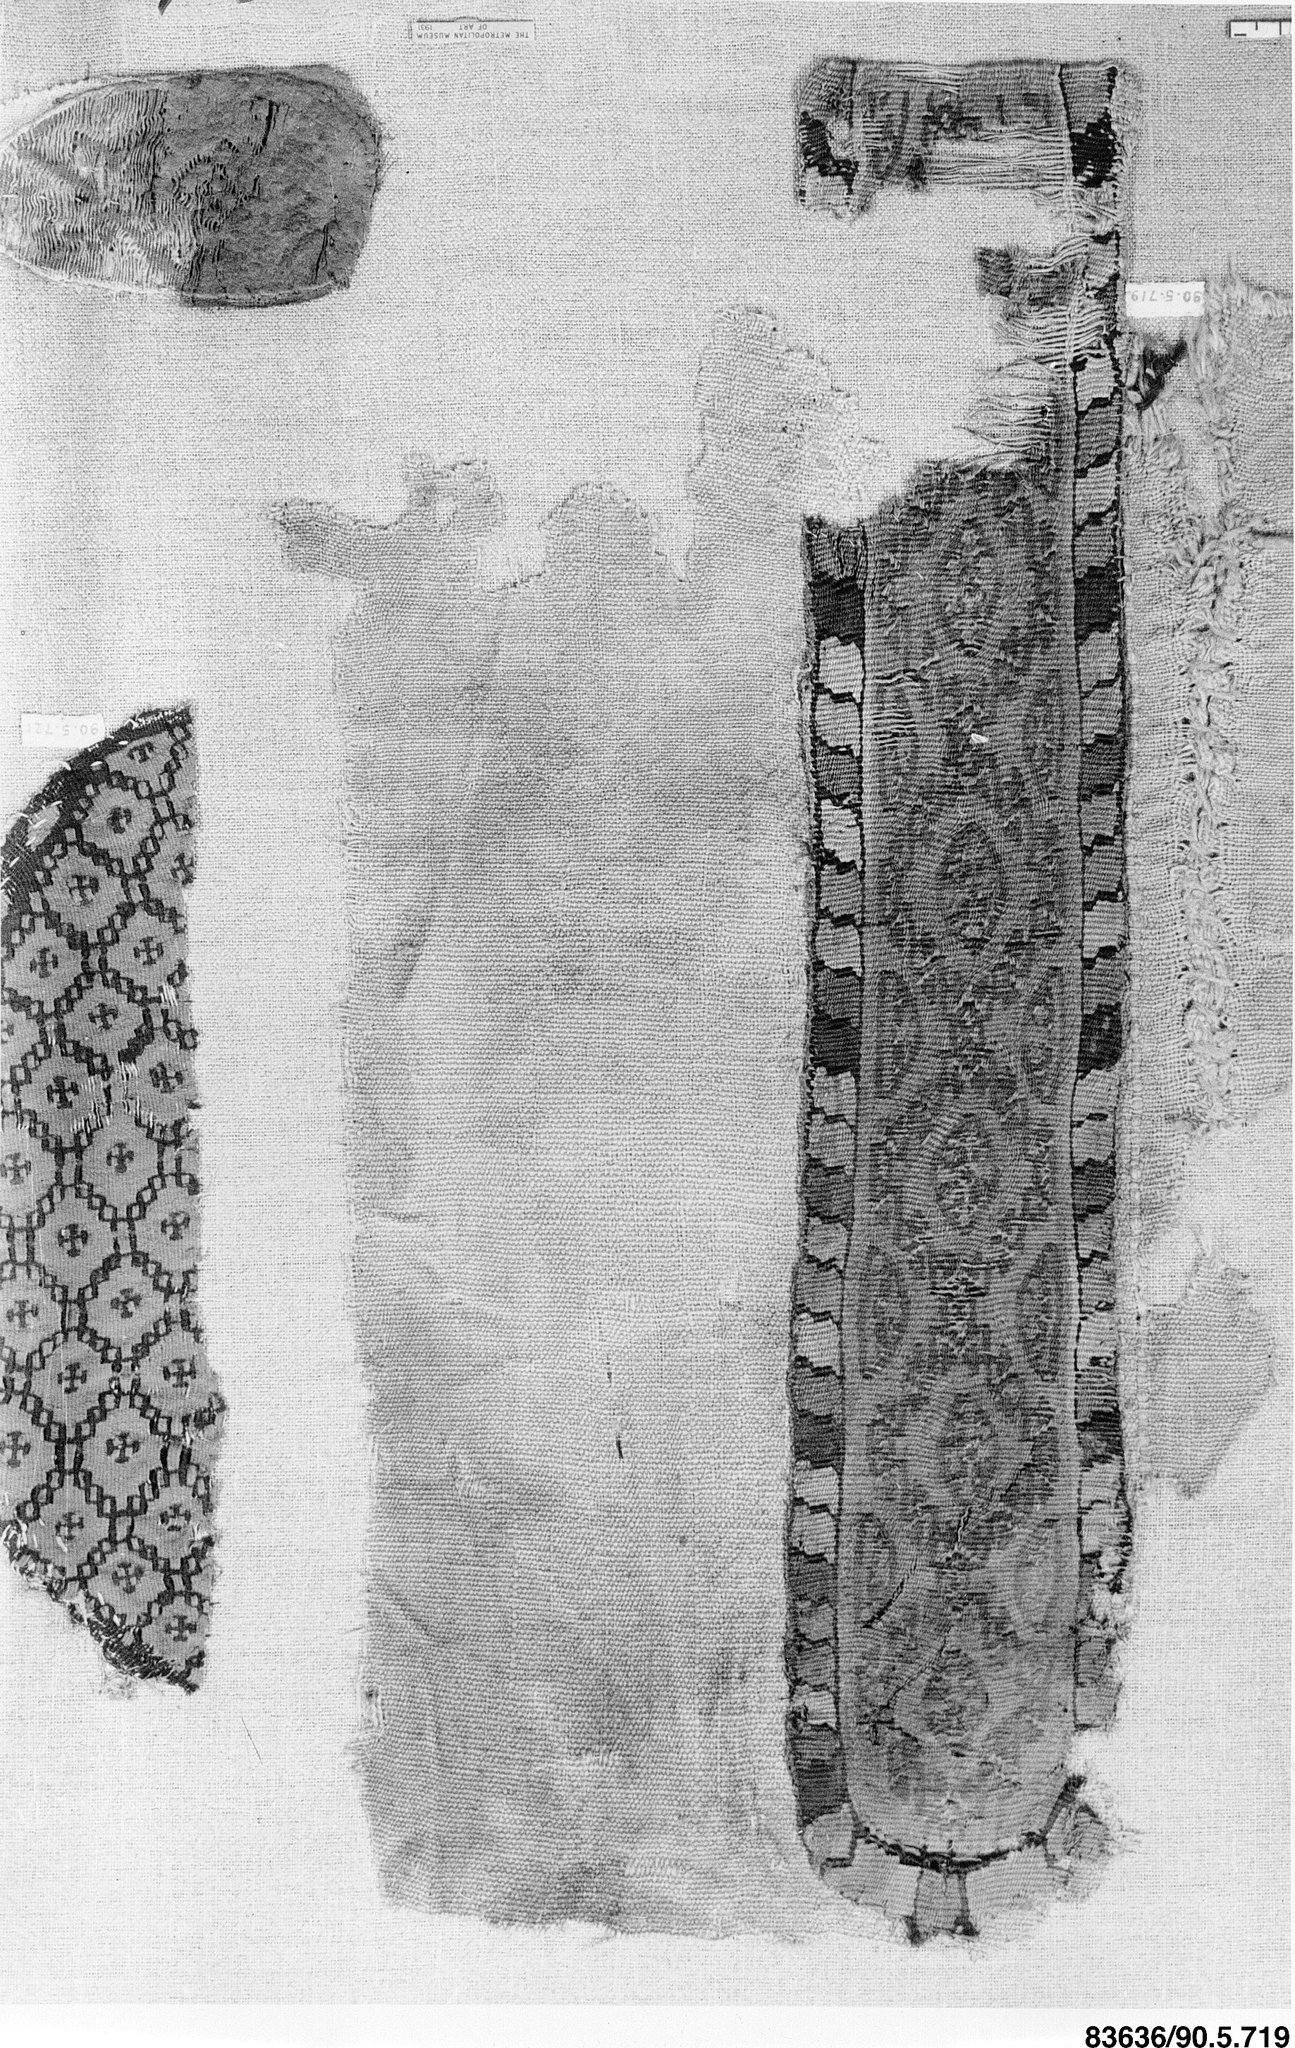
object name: textile fragment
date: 401-600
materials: linen, wool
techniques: weave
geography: egypt